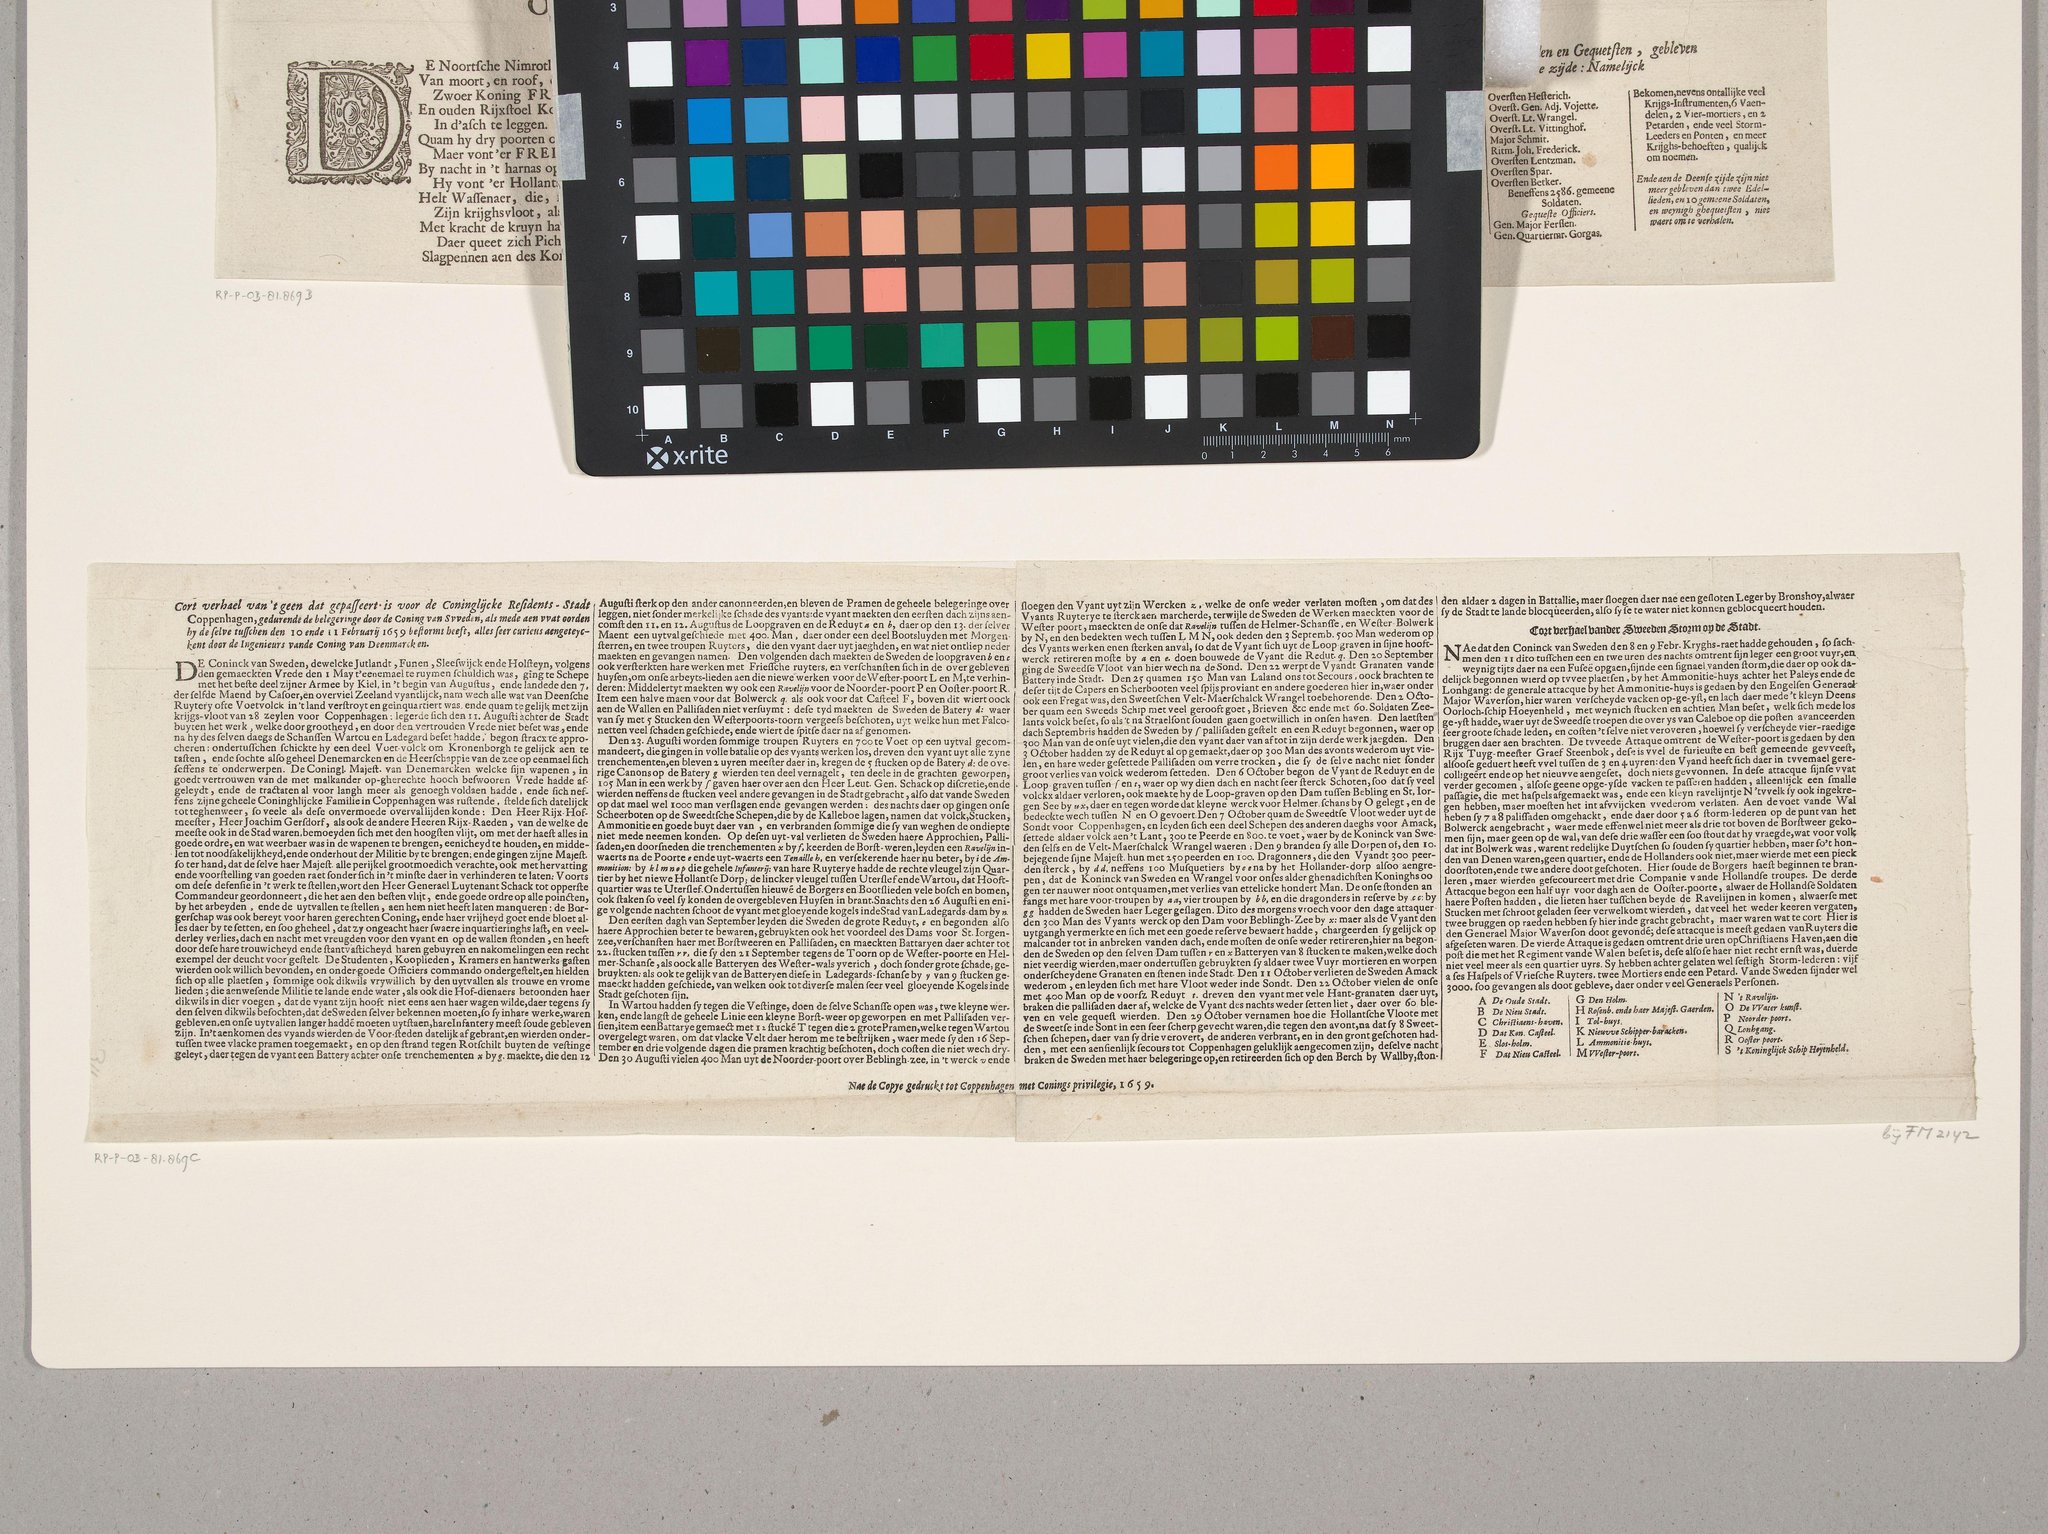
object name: print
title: Tekstblad bij de prent van het ontzet van Kopenhagen, 1659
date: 1659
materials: paper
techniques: letterpress printing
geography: amsterdam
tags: copenhagen (city)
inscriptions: date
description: Tekstblad bij de plattegrond van Kopenhagen met de Hollandse vloot die de belegering van de stad door de Zweden doorbreekt, 19-21 februari 1659. Beschrijving van de gebeurtenissen in 4 kolommen, op het eind de legenda A-S voor bij de kaart.